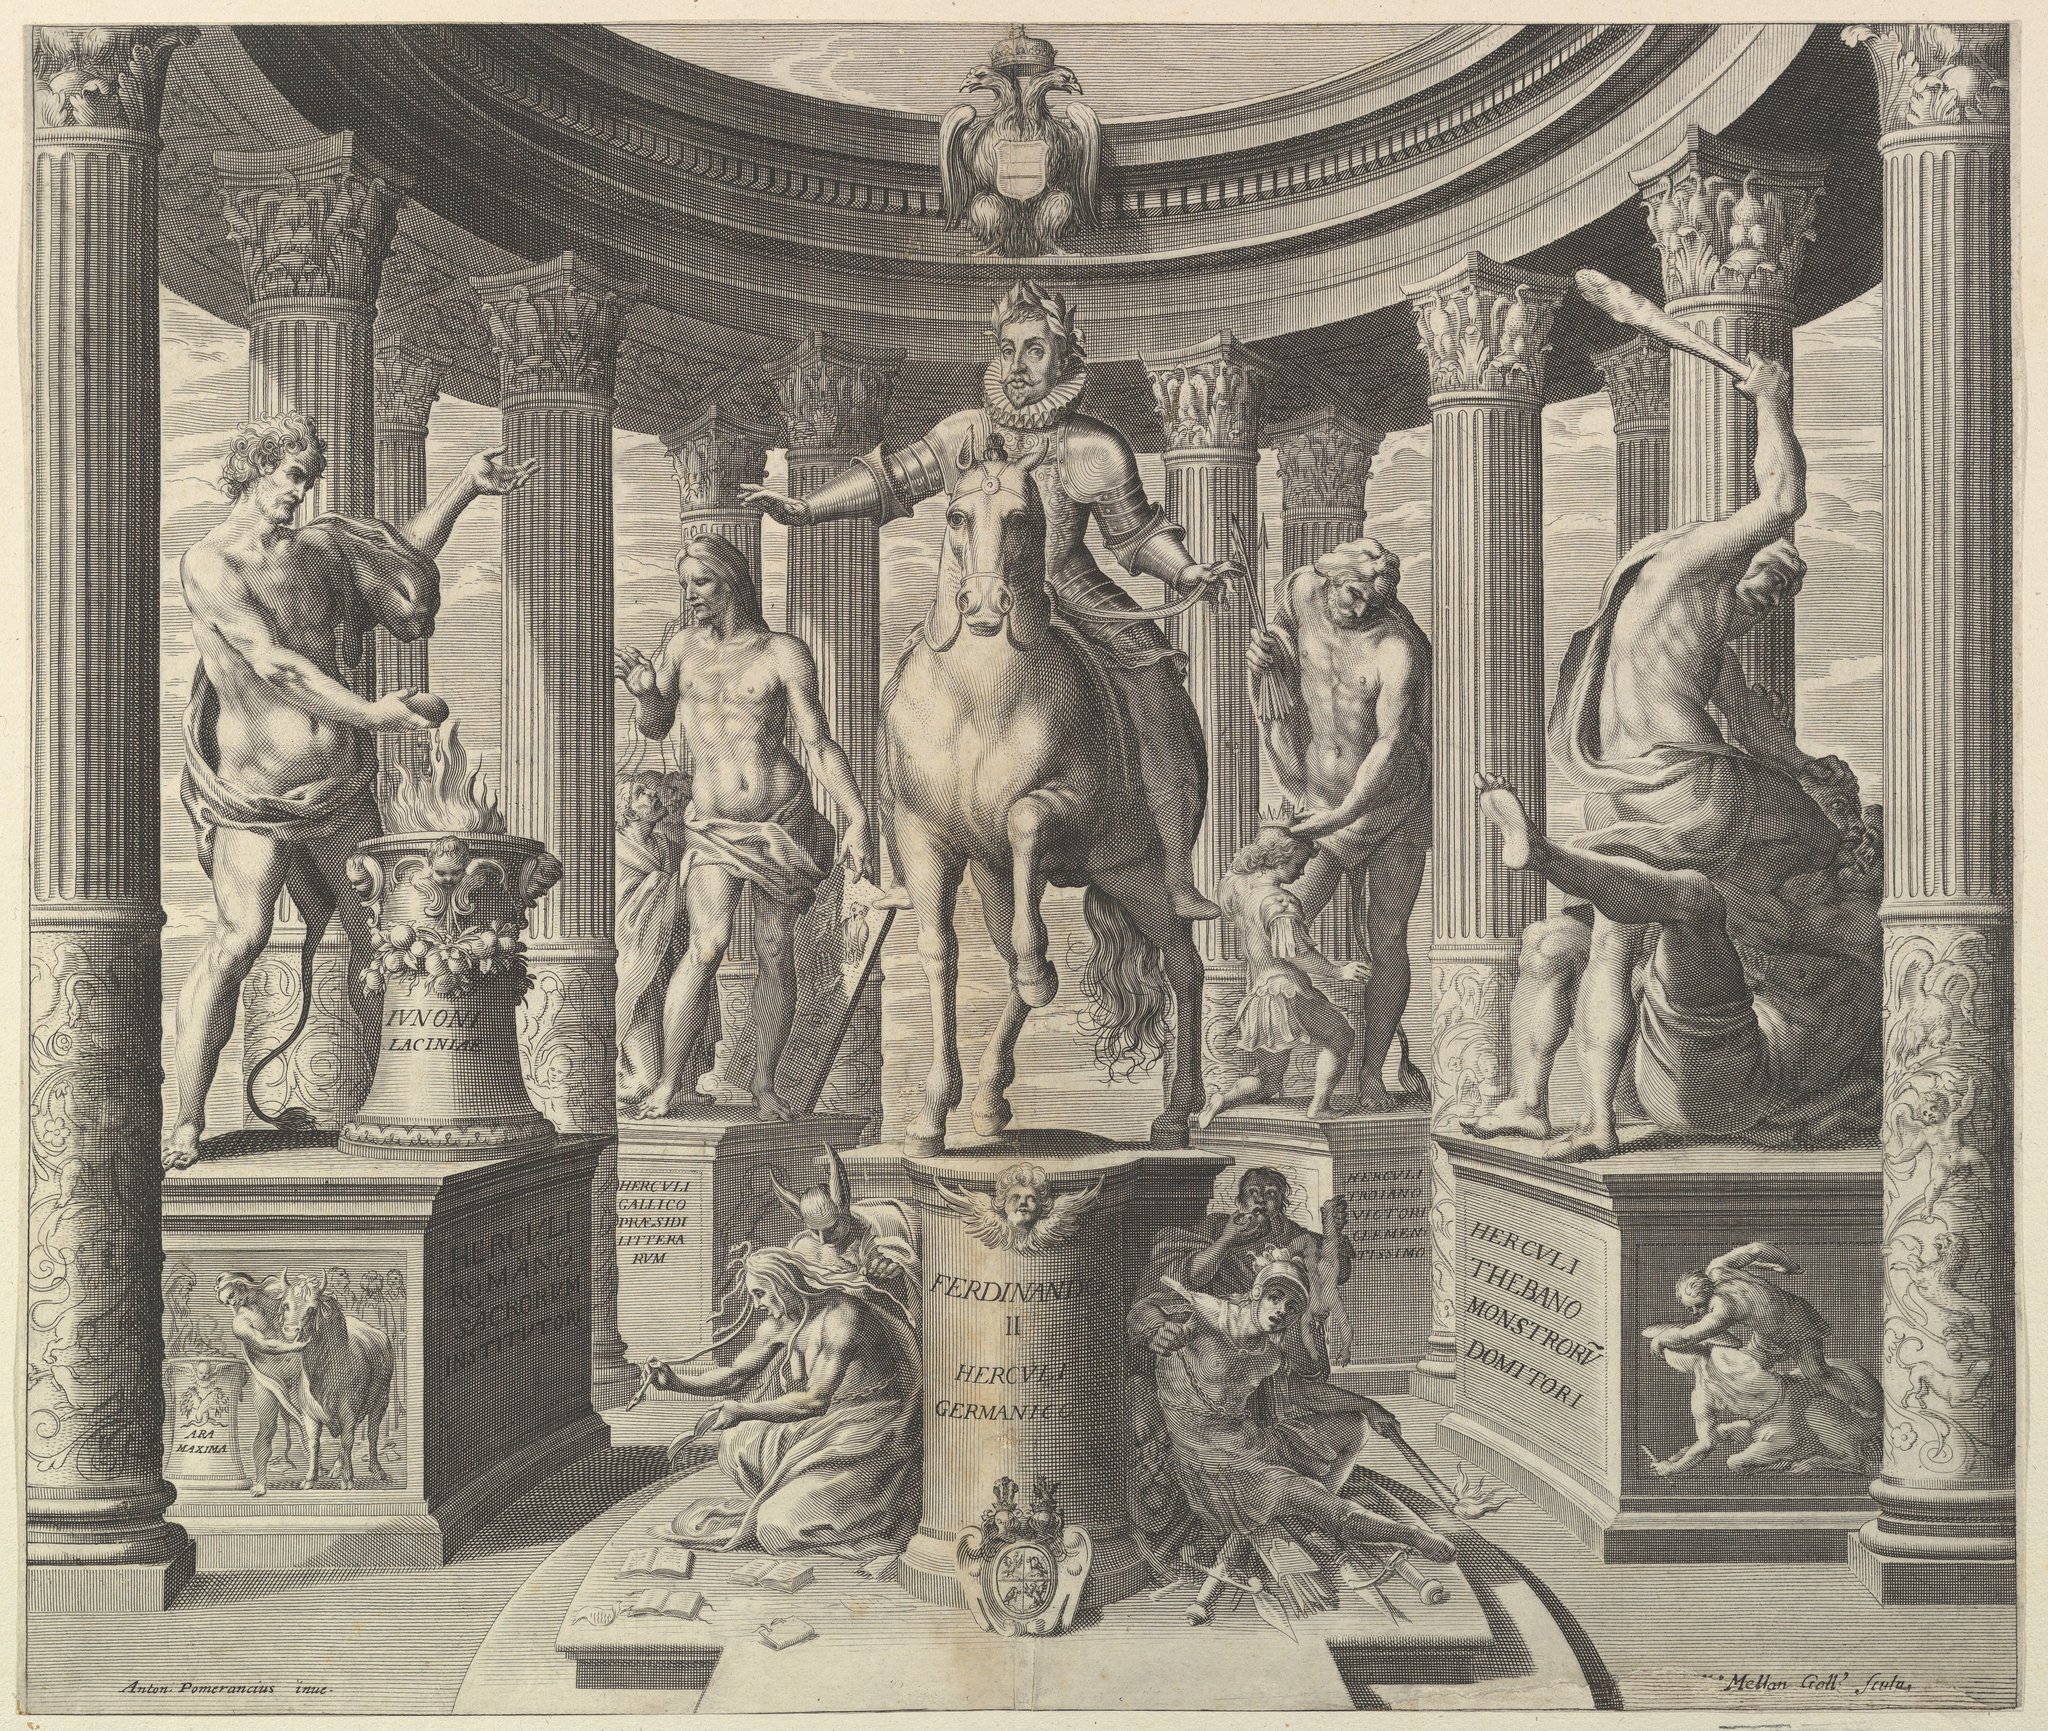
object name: print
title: Allegory on the Glory of Emperor Ferdinand II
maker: antonio circignano or circignani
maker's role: artist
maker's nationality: italian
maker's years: 1560-1620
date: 1600-1640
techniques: engraving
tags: sculpture,historical figures,men,horses